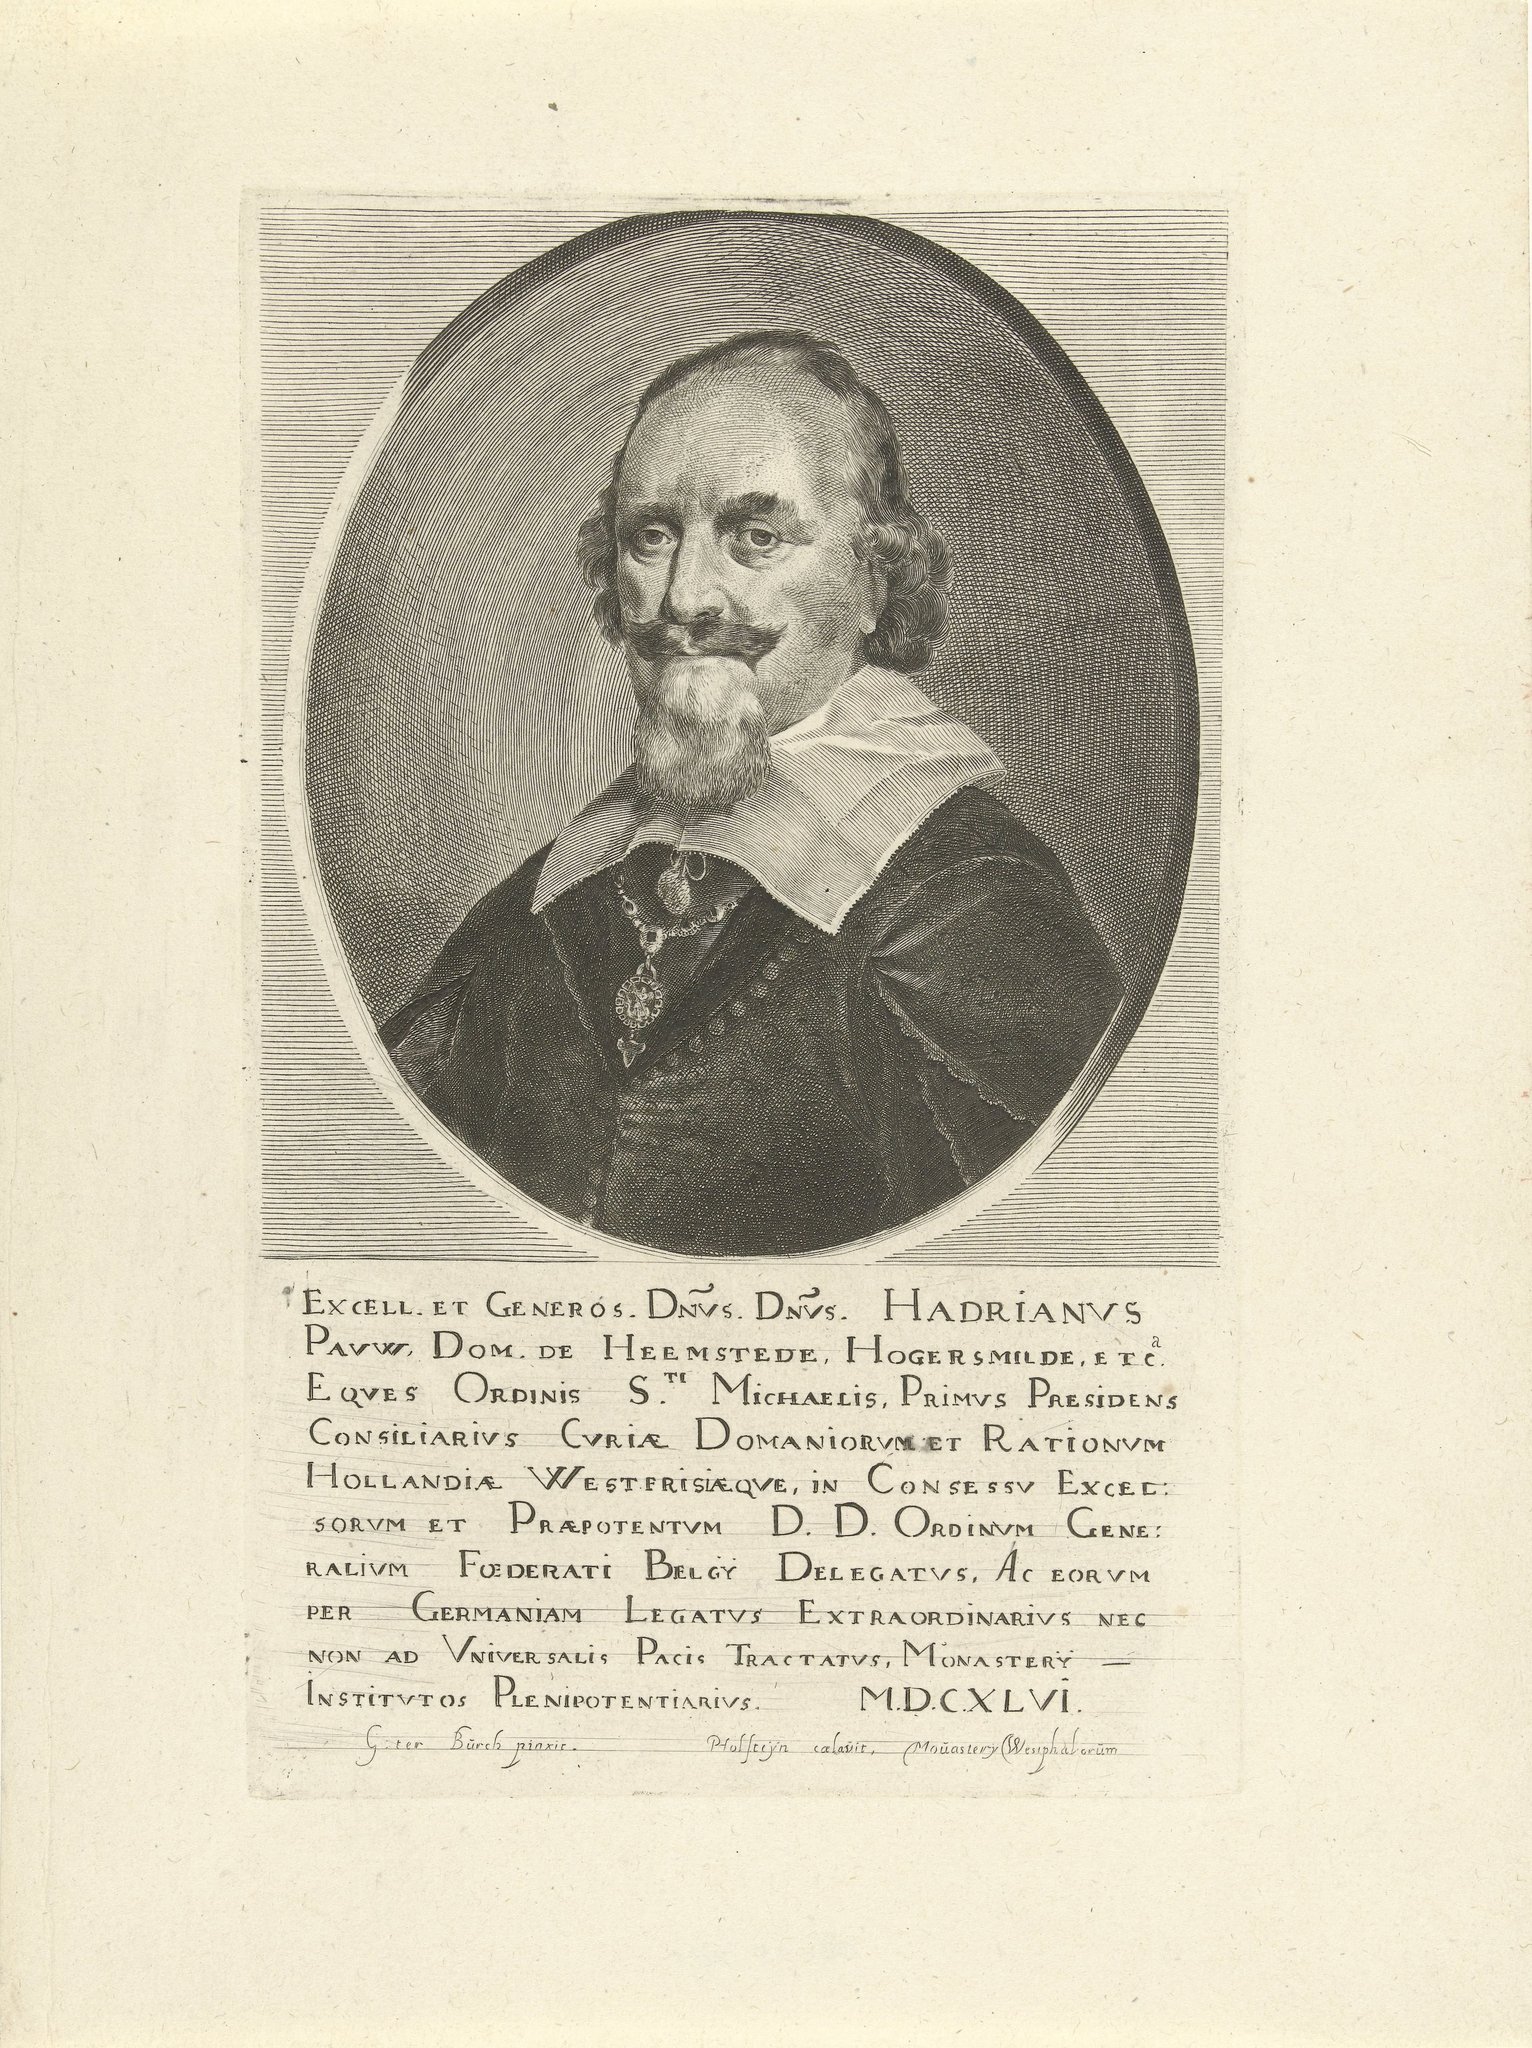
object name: print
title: Portret van Adriaen Pauw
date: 1646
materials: paper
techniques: engraving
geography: northern netherlands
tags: amsterdam, politician, adriaen pauw (1585-1653)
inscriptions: date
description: Portret naar links van Adriaen Pauw in een ovaal. Onder het portret tien regels in het Latijn.